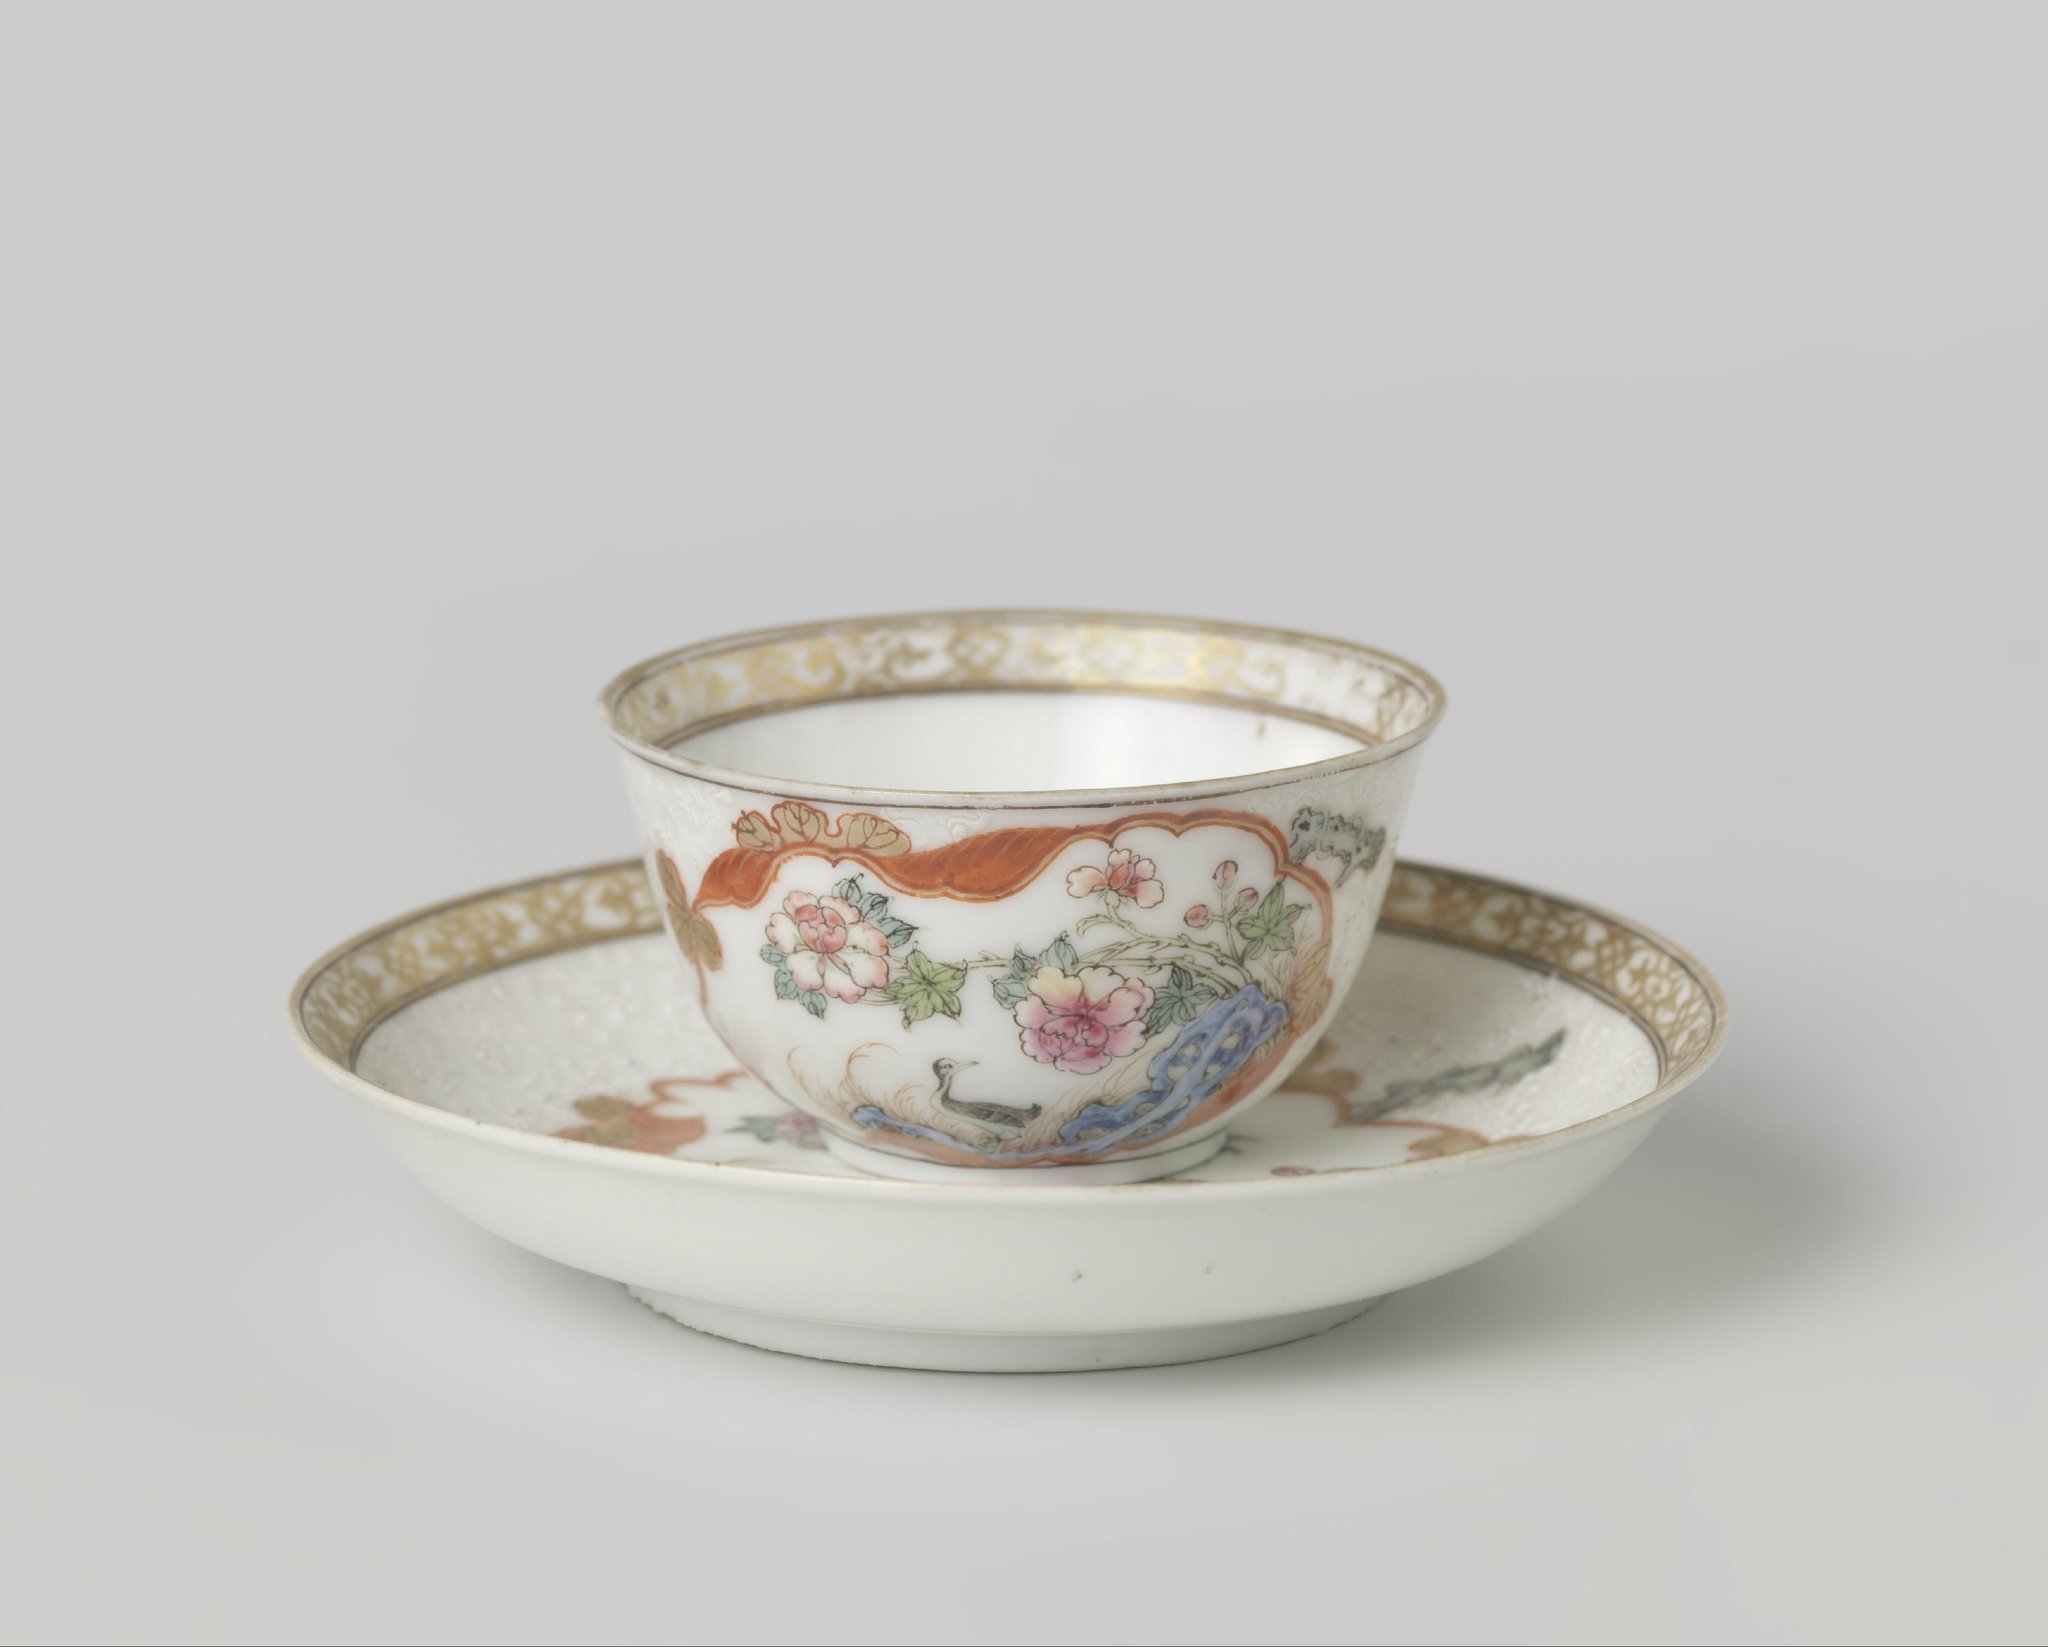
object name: kop en schotel, kop en schotel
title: Bell-shaped cup and saucer with crane near a peony plant and rock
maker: Anonymous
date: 1725-1749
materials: glaze, gold, paint, porcelain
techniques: firing, gilding, turning, vitrification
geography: china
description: Kop en schotel, versierd met bianco sopra bianco waarop een goud en rood blad met landschap bloemen en vogel.